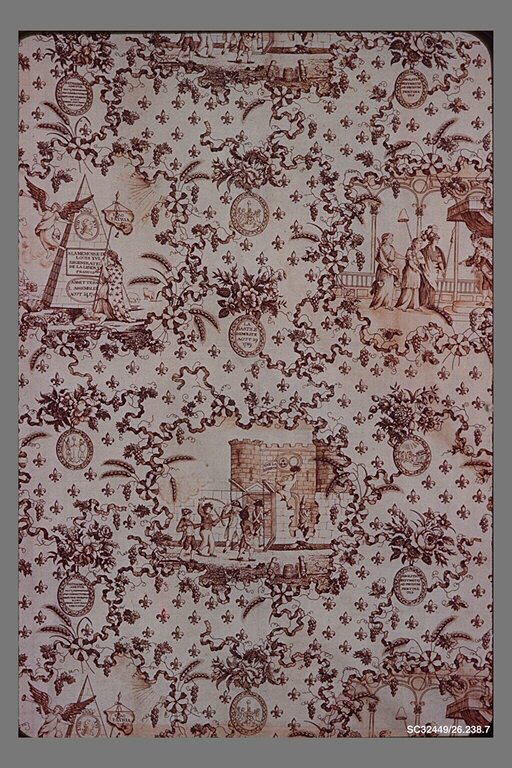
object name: piece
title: The Fall of the Bastille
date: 1790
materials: cotton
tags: french revolution